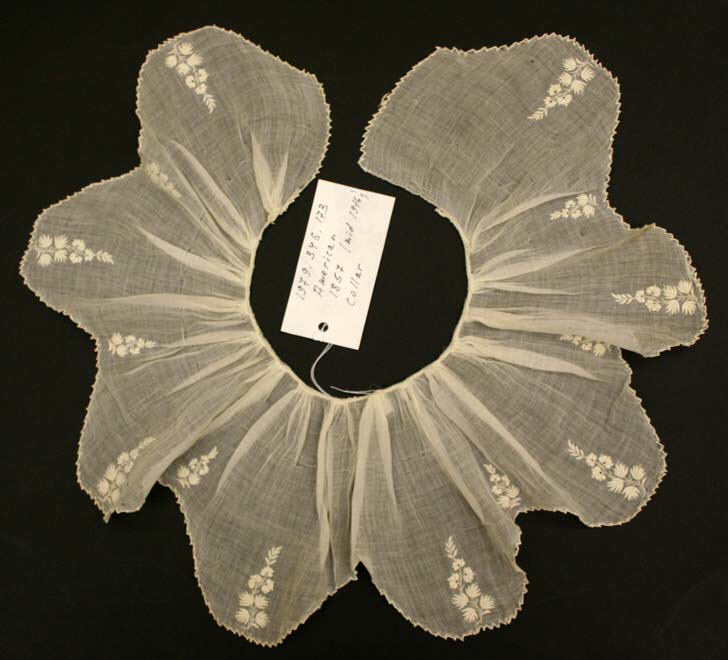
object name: collar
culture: american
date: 1857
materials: cotton